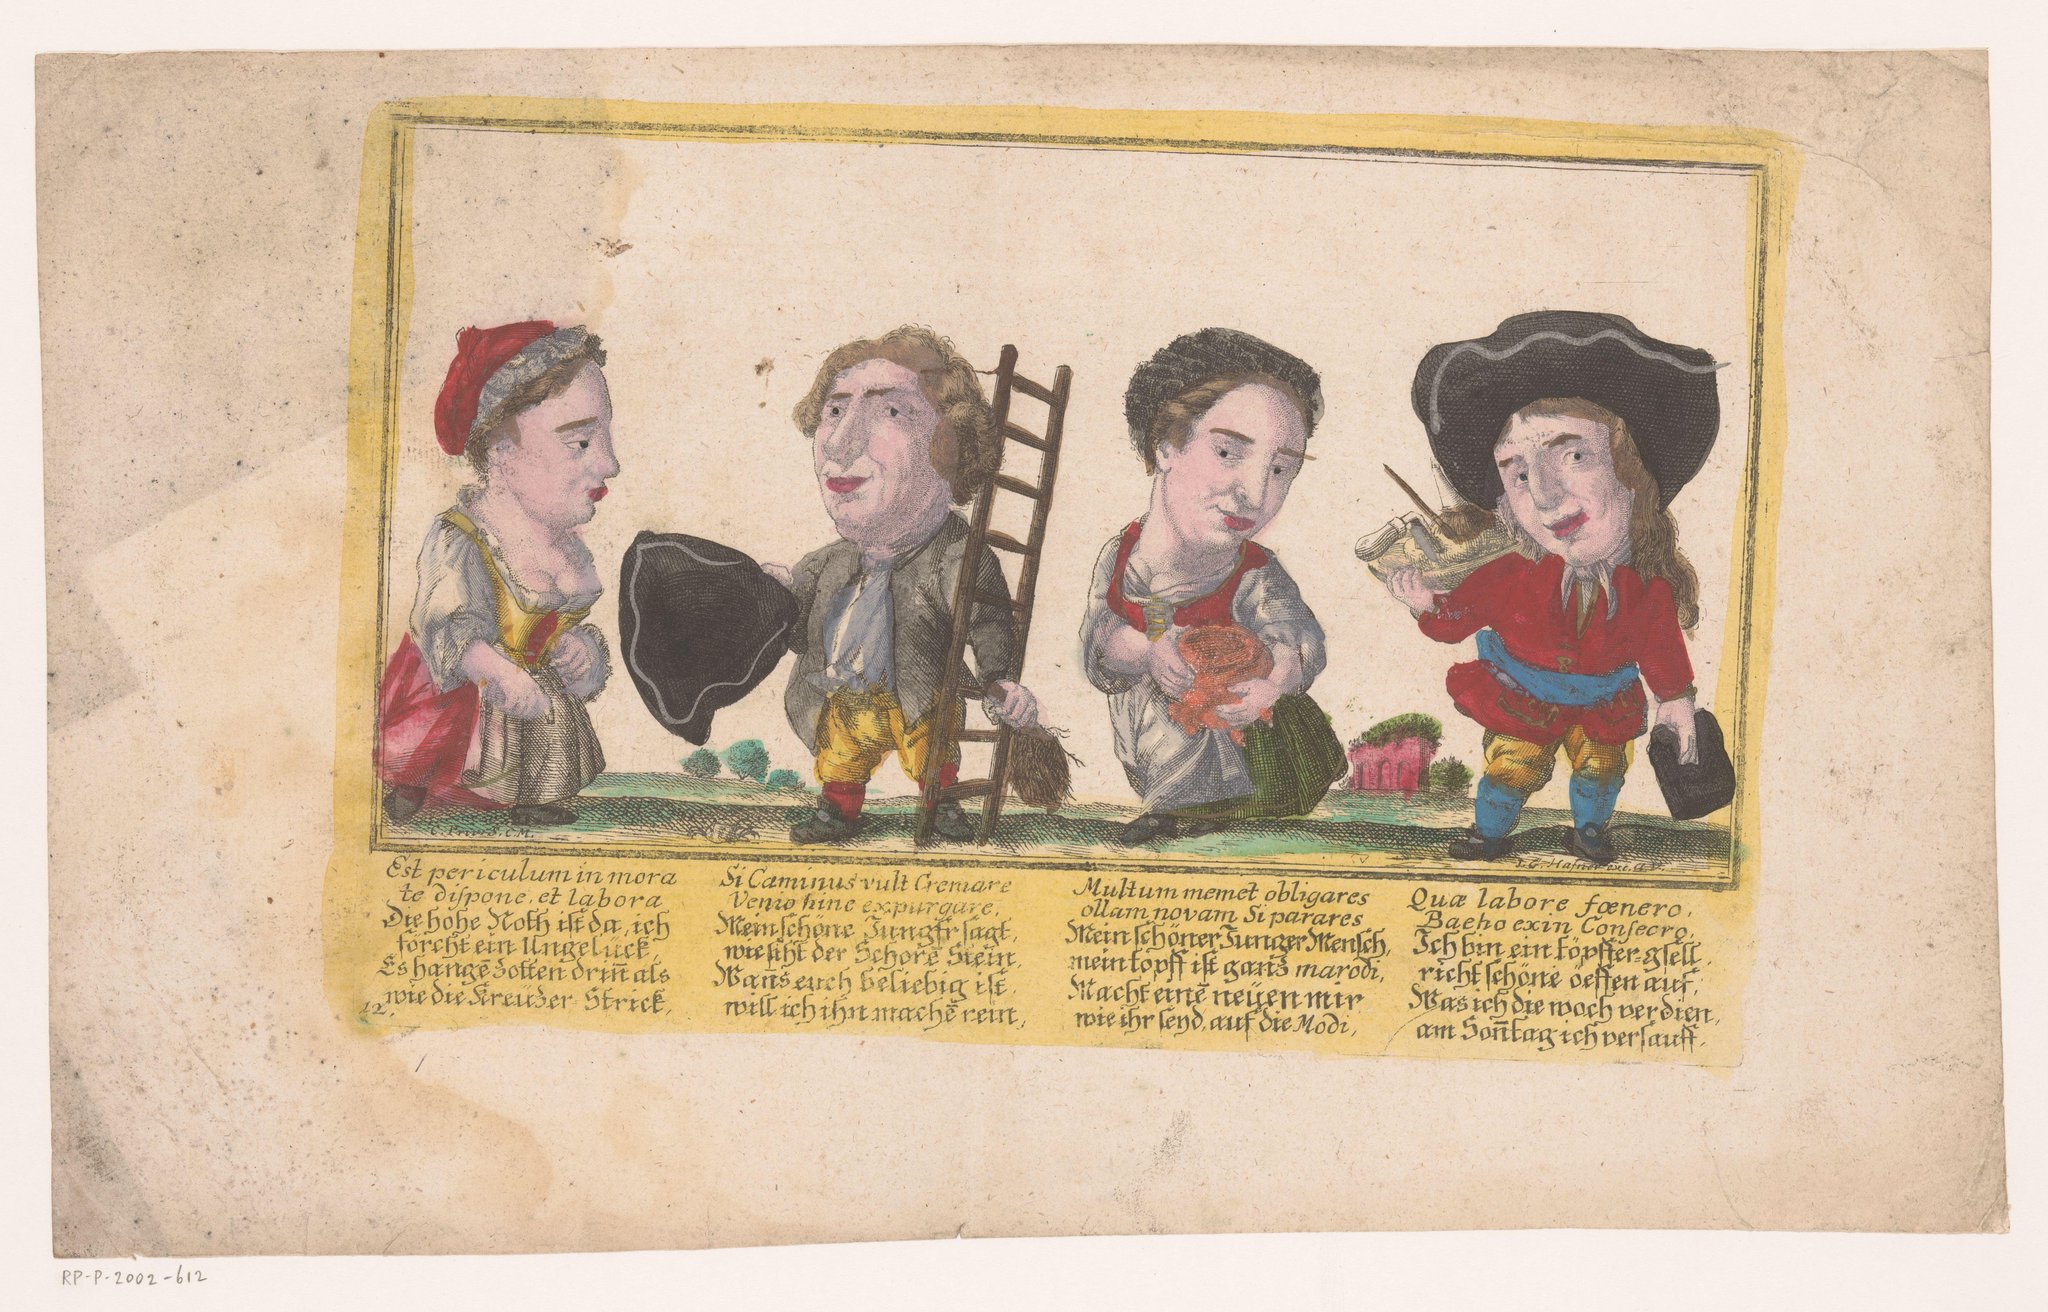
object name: print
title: Twee mannen en twee vrouwen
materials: paper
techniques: engraving, hand coloring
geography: germany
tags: little people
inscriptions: collector's mark: Lugt 2228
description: Twee mannen en twee vrouwen (kleine mensen).